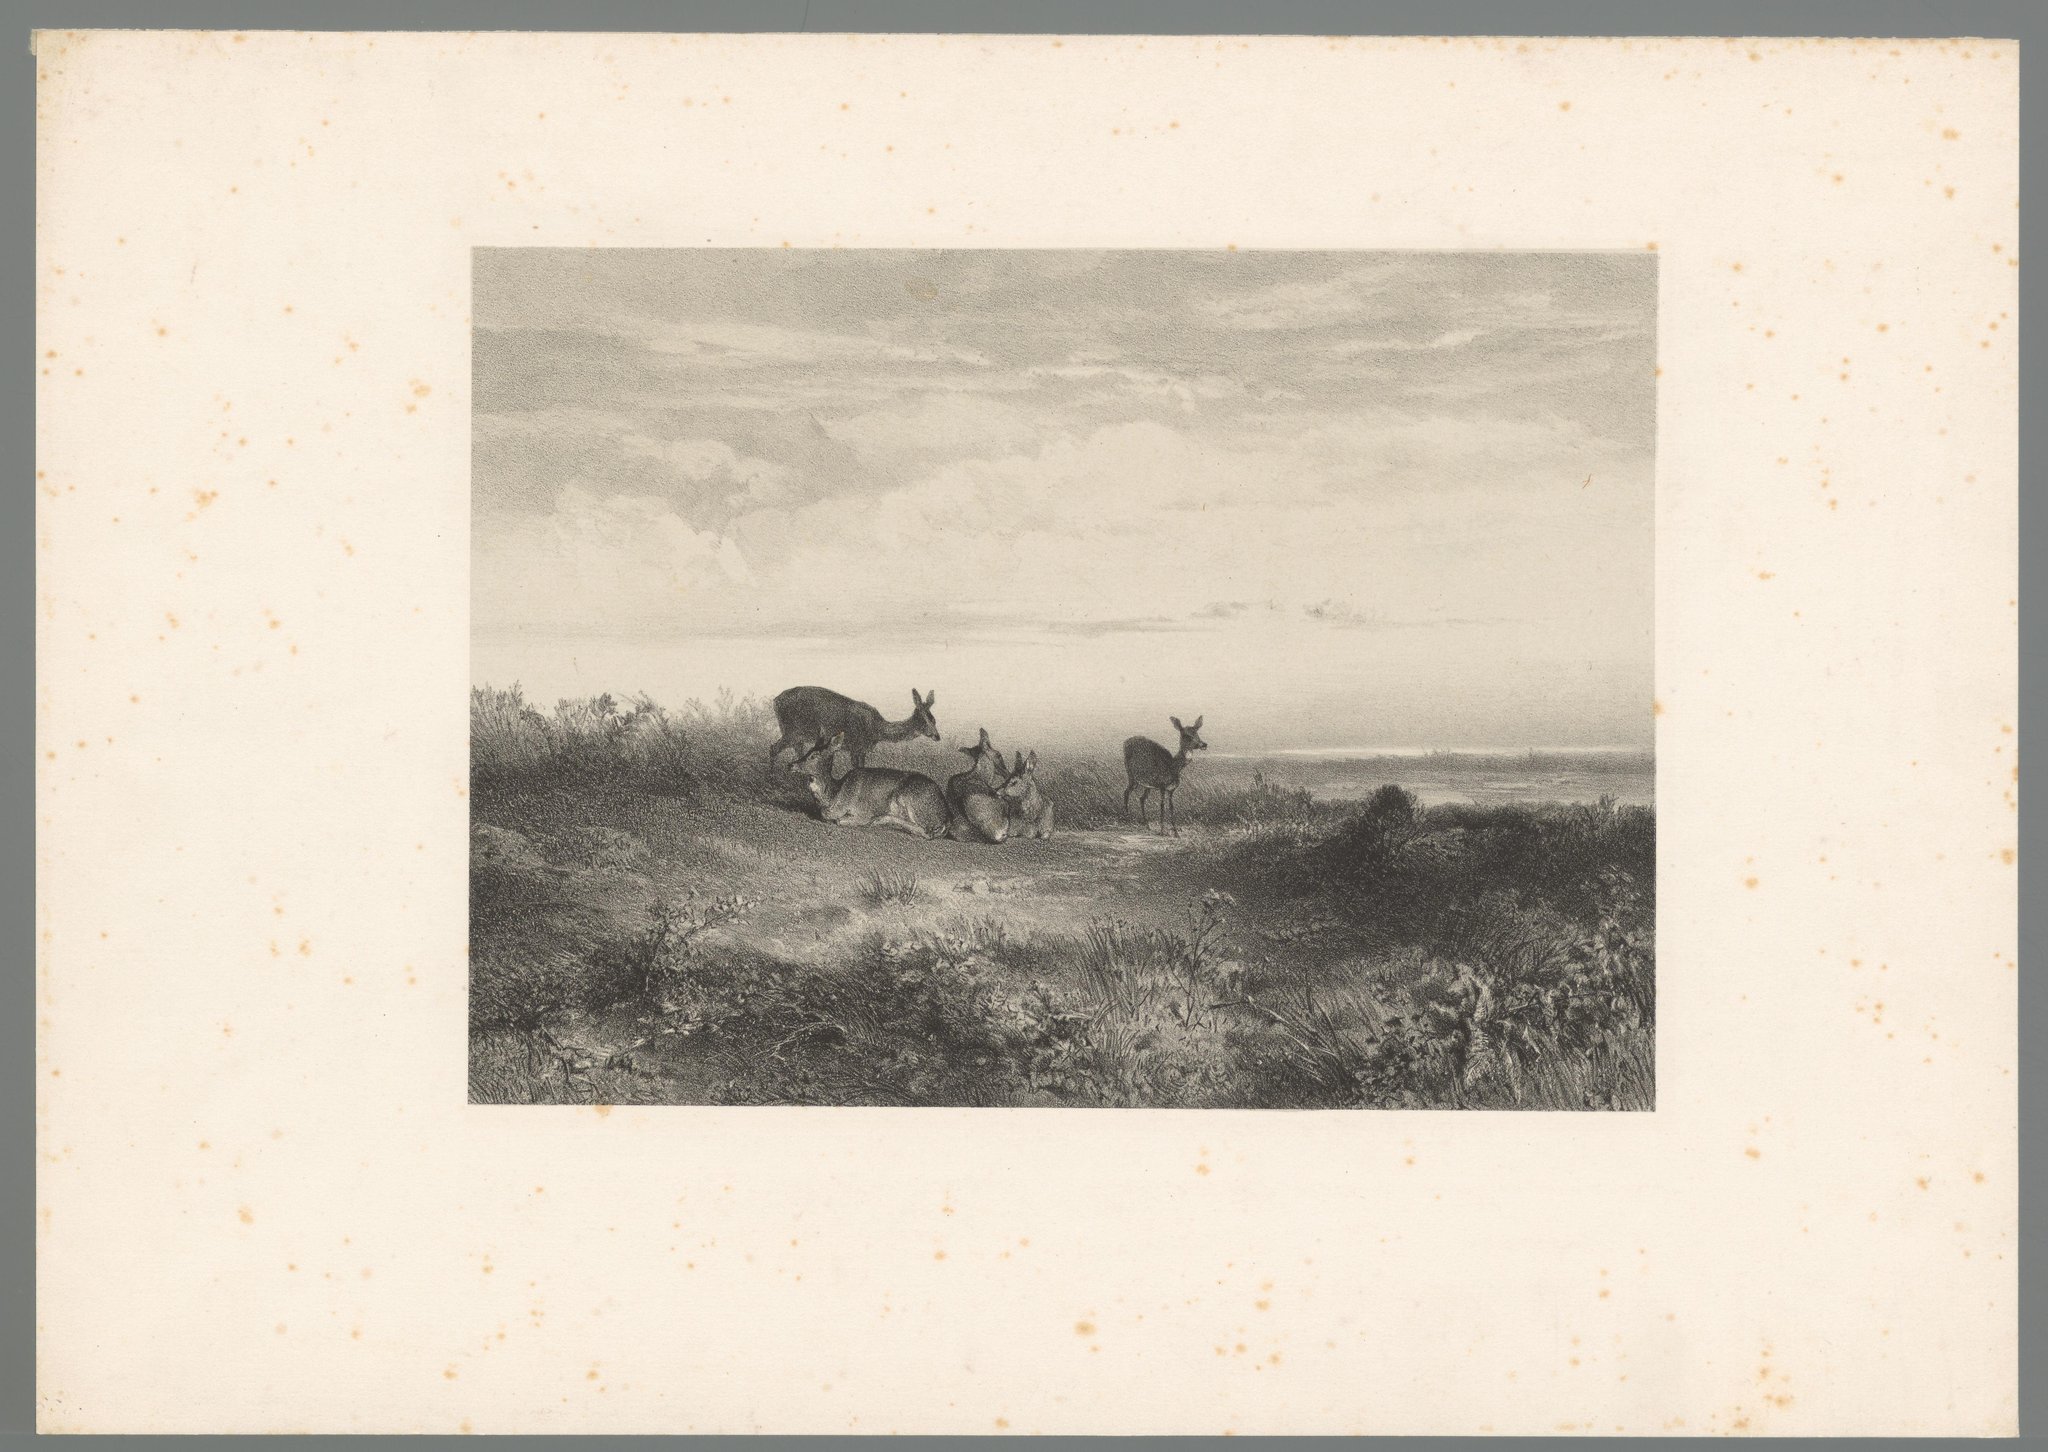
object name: print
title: Herten in een landschap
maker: karl bodmer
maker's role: draughtsman, painter, print maker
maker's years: 1809-1893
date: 1819-1854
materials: paper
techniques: lithograph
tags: hoofed animals: deer, meadow, pasture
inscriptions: collector's mark: Lugt 2228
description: De andere staat van deze prent is onderdeel van de serie 'Les Artistes Anciens et Modernes'.